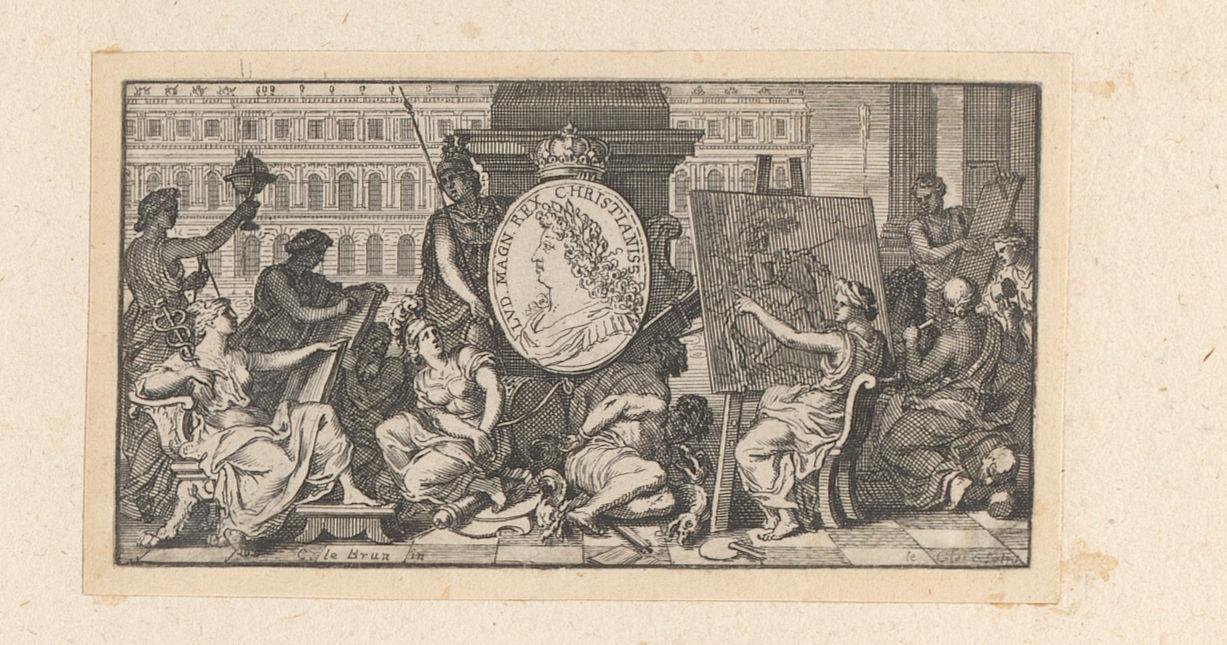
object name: book illustration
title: Vignet met de verschillende Kunsten rond een portret van Lodewijk XIV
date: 1687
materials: paper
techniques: etching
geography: versailles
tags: lodewijk xiv (koning van frankrijk), the arts; artists, historical persons, vignette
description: Prent uit: Rainssant, Pierre. Explication des tableaux de la galerie de Versailles (...). Versailles: François Muguet, 1687.